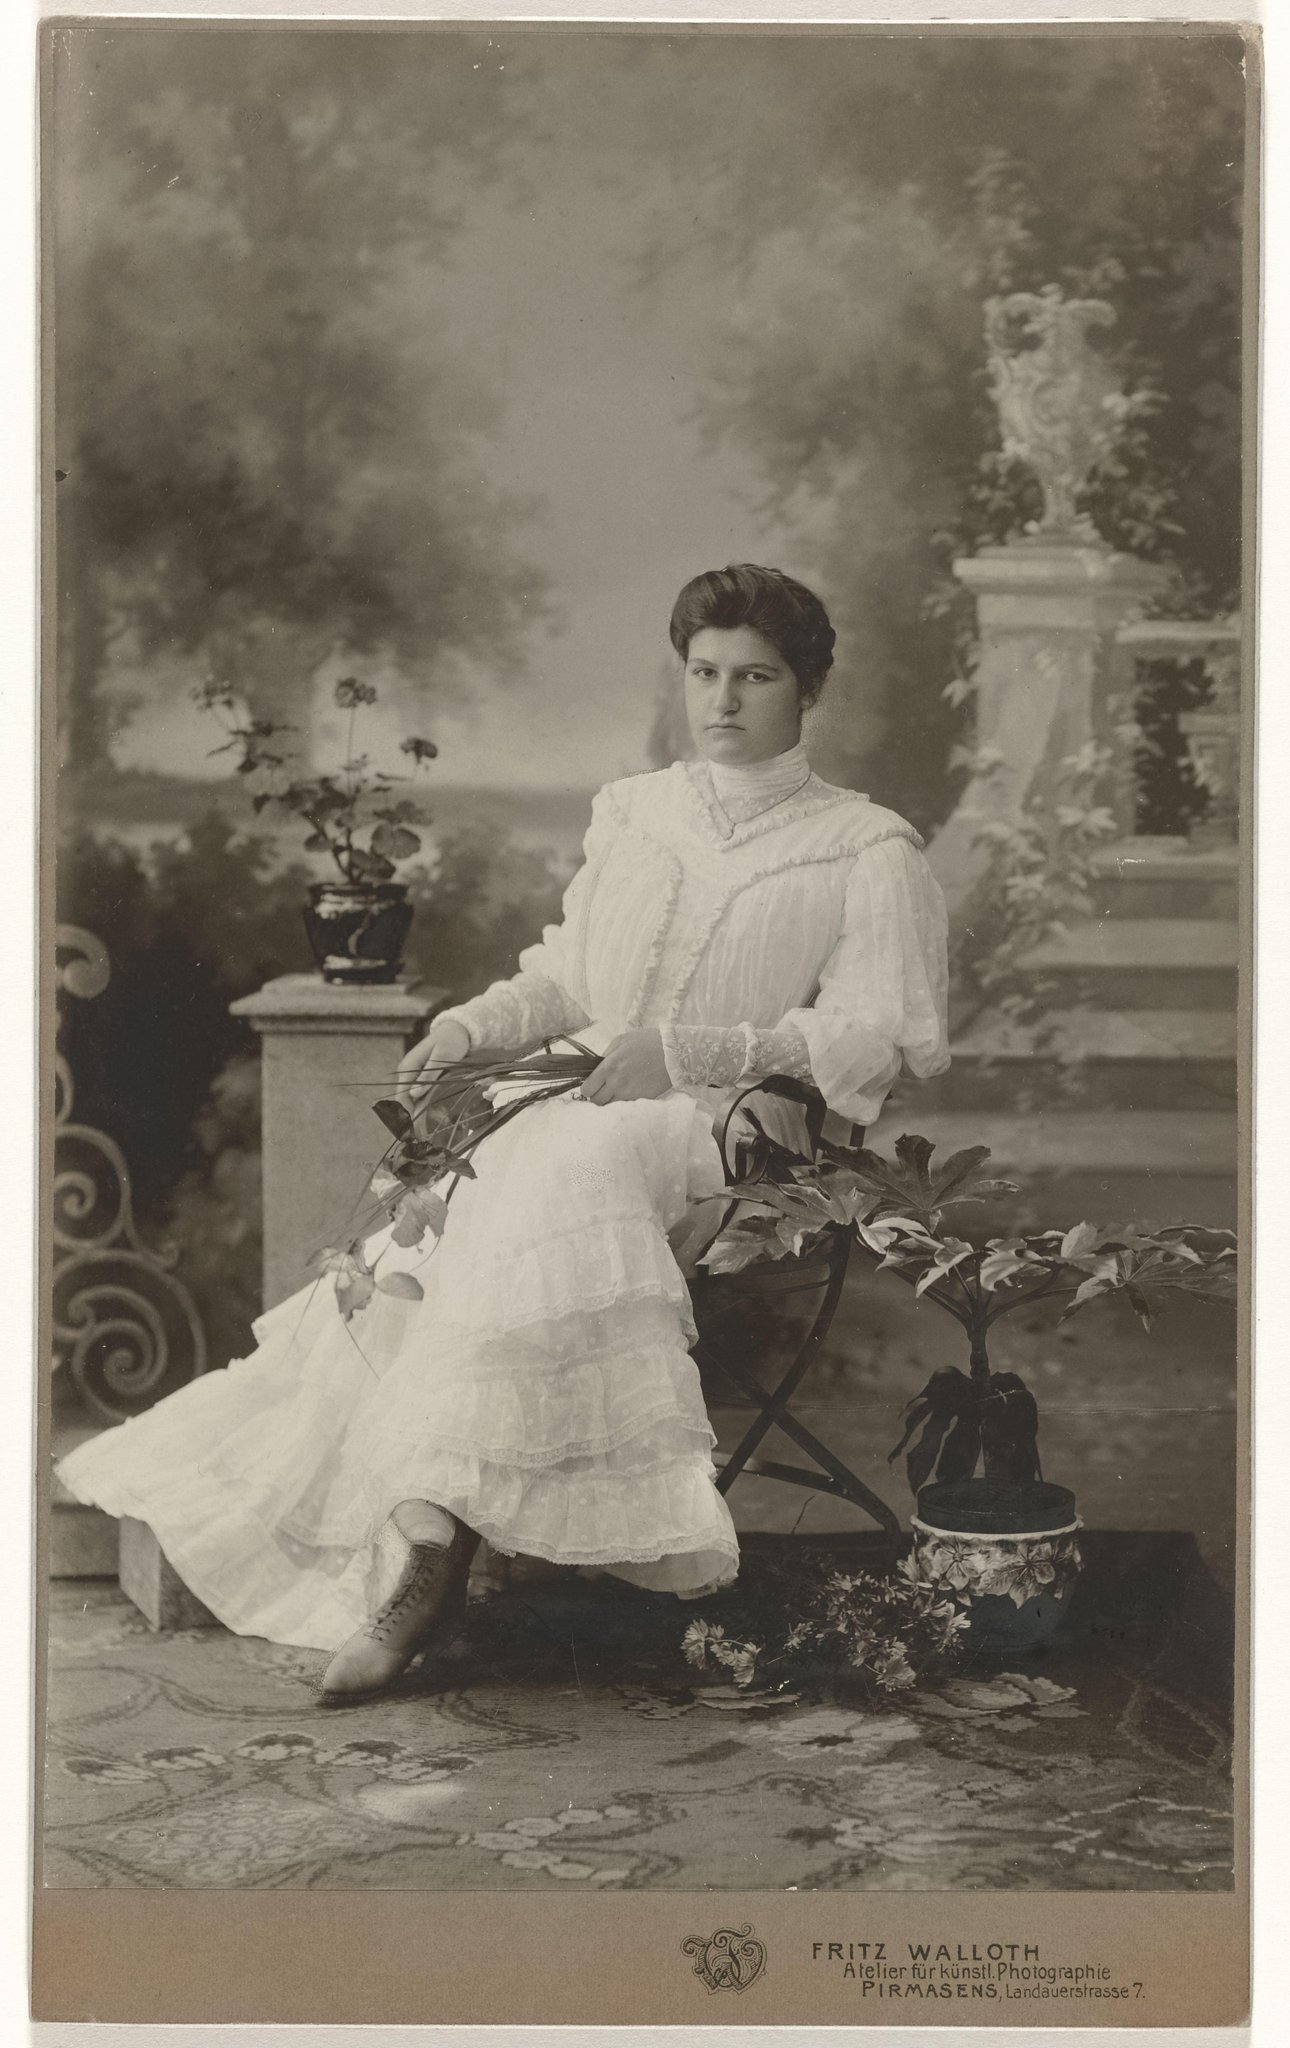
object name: photograph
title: Mathilde Wachenheimer-Wertheimer als jonge vrouw gezeten voor een decor met een trap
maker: fritz walloth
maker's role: fotograaf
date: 1885-1900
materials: photographic support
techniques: gelatin silver print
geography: pirmasens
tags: sobibór, mathilde wachenheimer-wertheimer, stuttgart